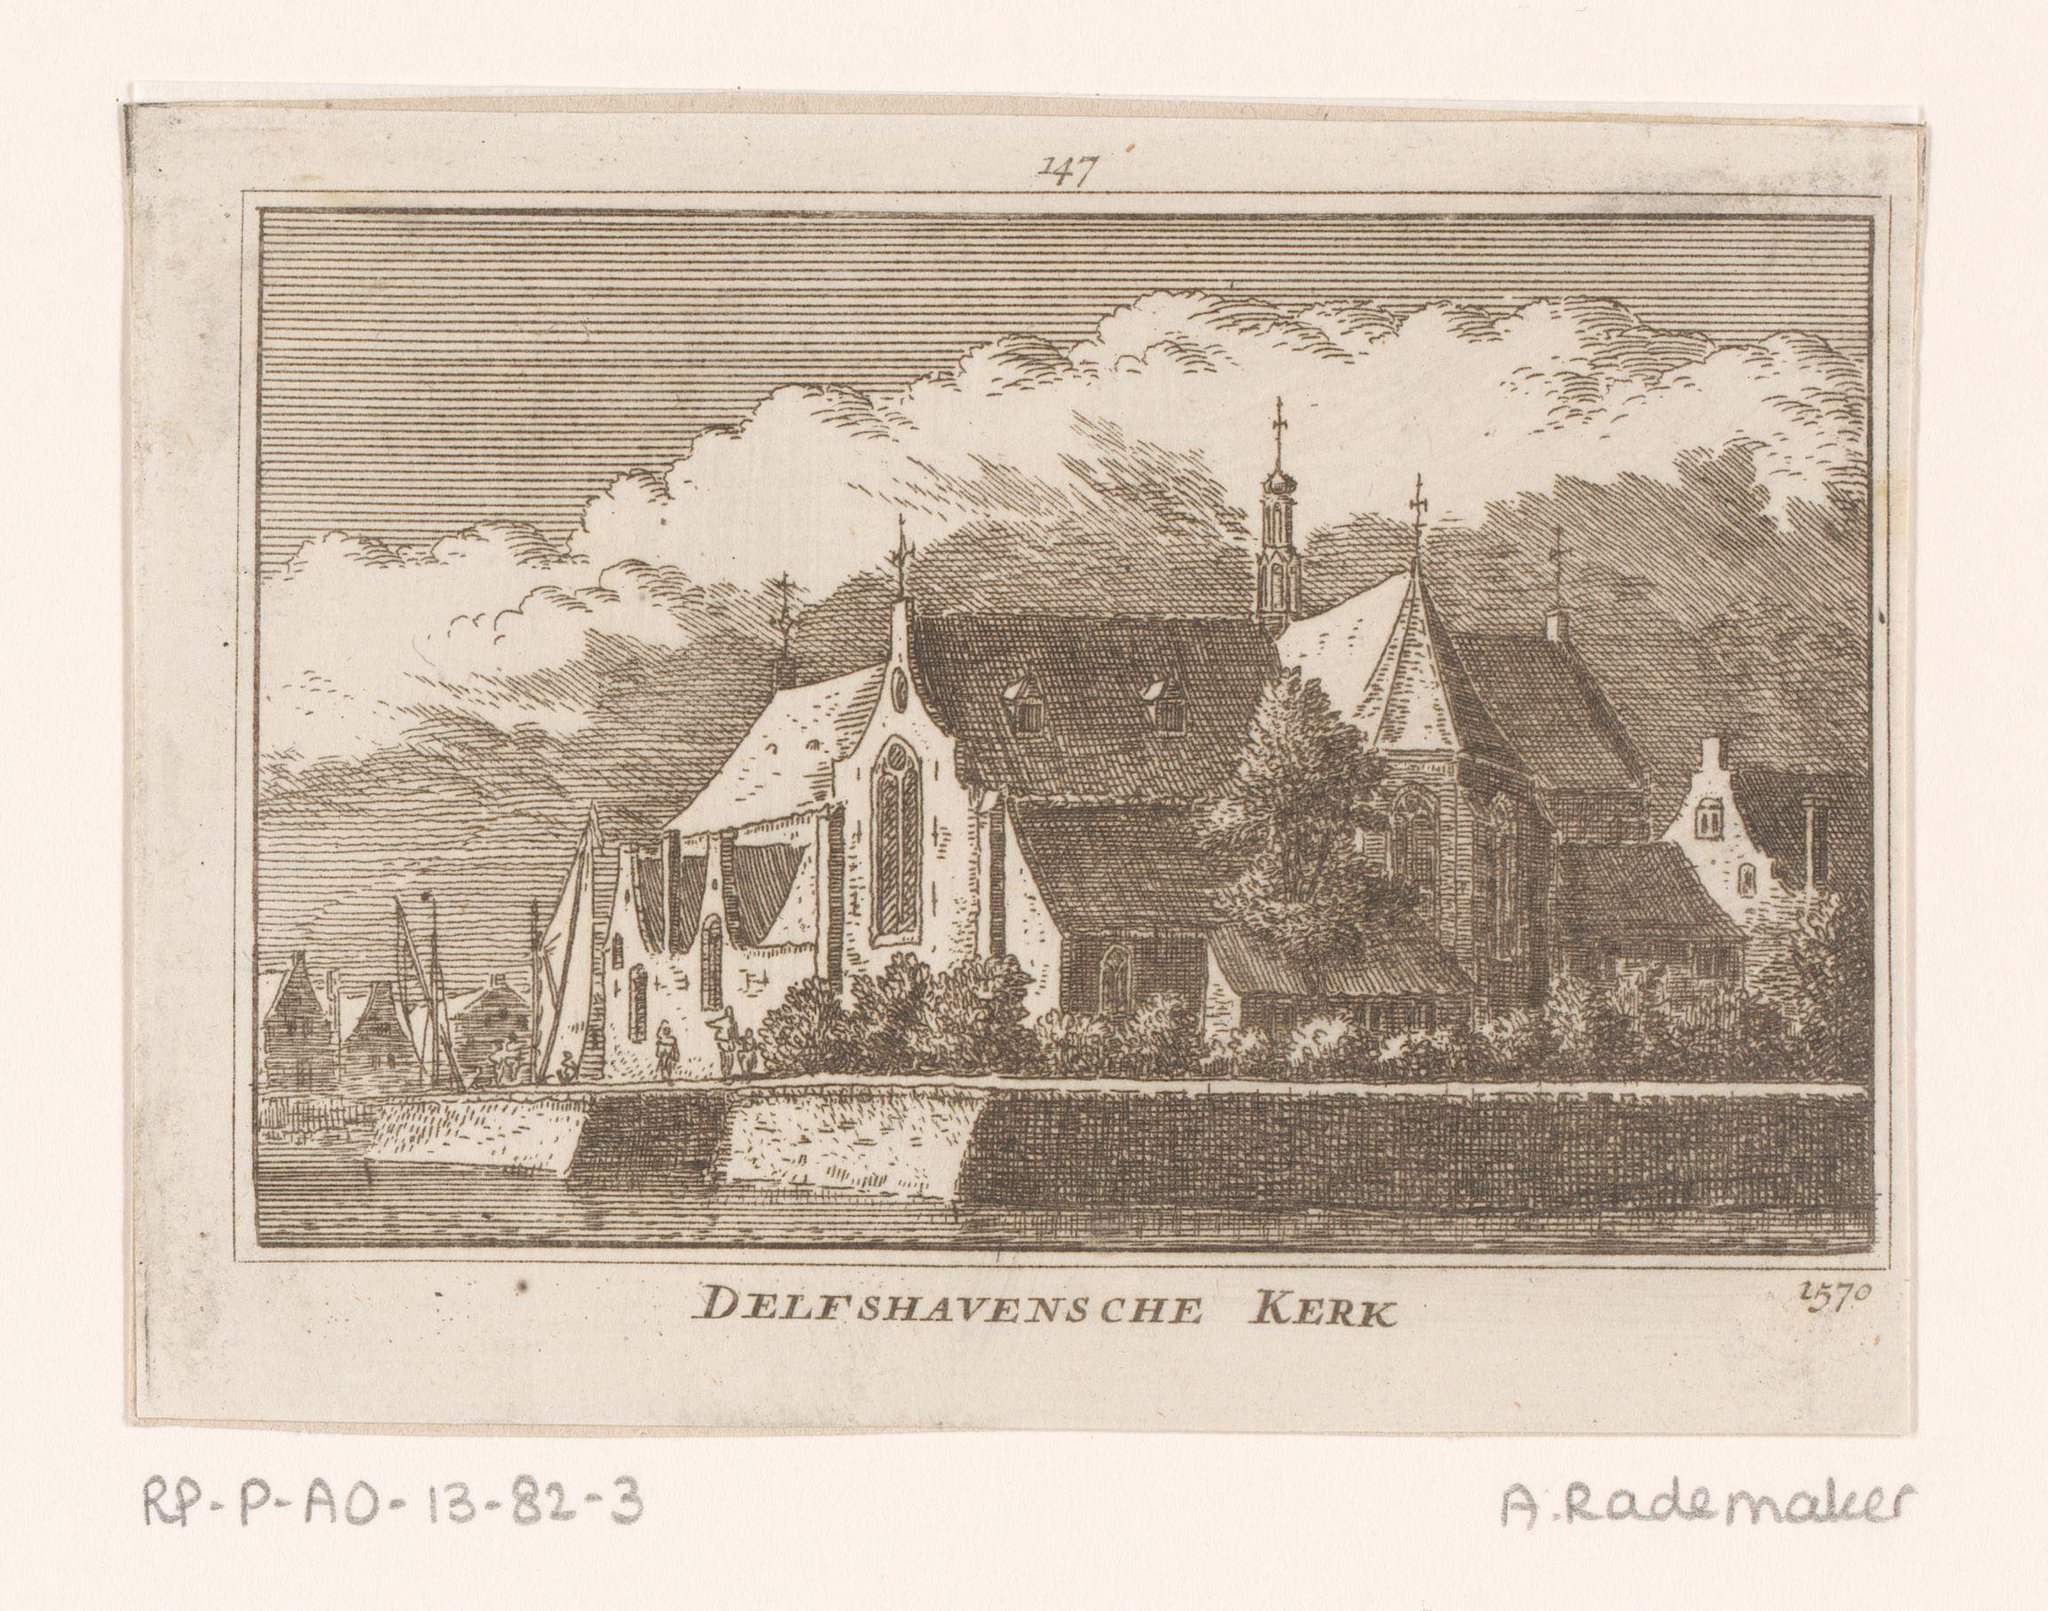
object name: print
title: Delfshavensche Kerk 1570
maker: abraham rademaker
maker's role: draughtsman, print maker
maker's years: 1676-1735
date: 1725-1803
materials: paper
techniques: engraving, etching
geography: amsterdam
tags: riding a horse, ass, or mule; rider, horseman, church (exterior), delfshaven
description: Prent ook gebruikt in: Rademaker, Abraham. Kabinet van Nederlandsche outheden en gezichten: vervat in 300 konstplaaten (…). 2 delen. Amsterdam: Willem Barents, 1725, dl. 1, ill. 147. Na 1725 is deze prent nog in verschillende heruitgaven verschenen, uitgegeven in 1727-1733, 1770-1771 en 1792-1803. Uit welke uitgave het huidige exemplaar precies komt is niet na te gaan.